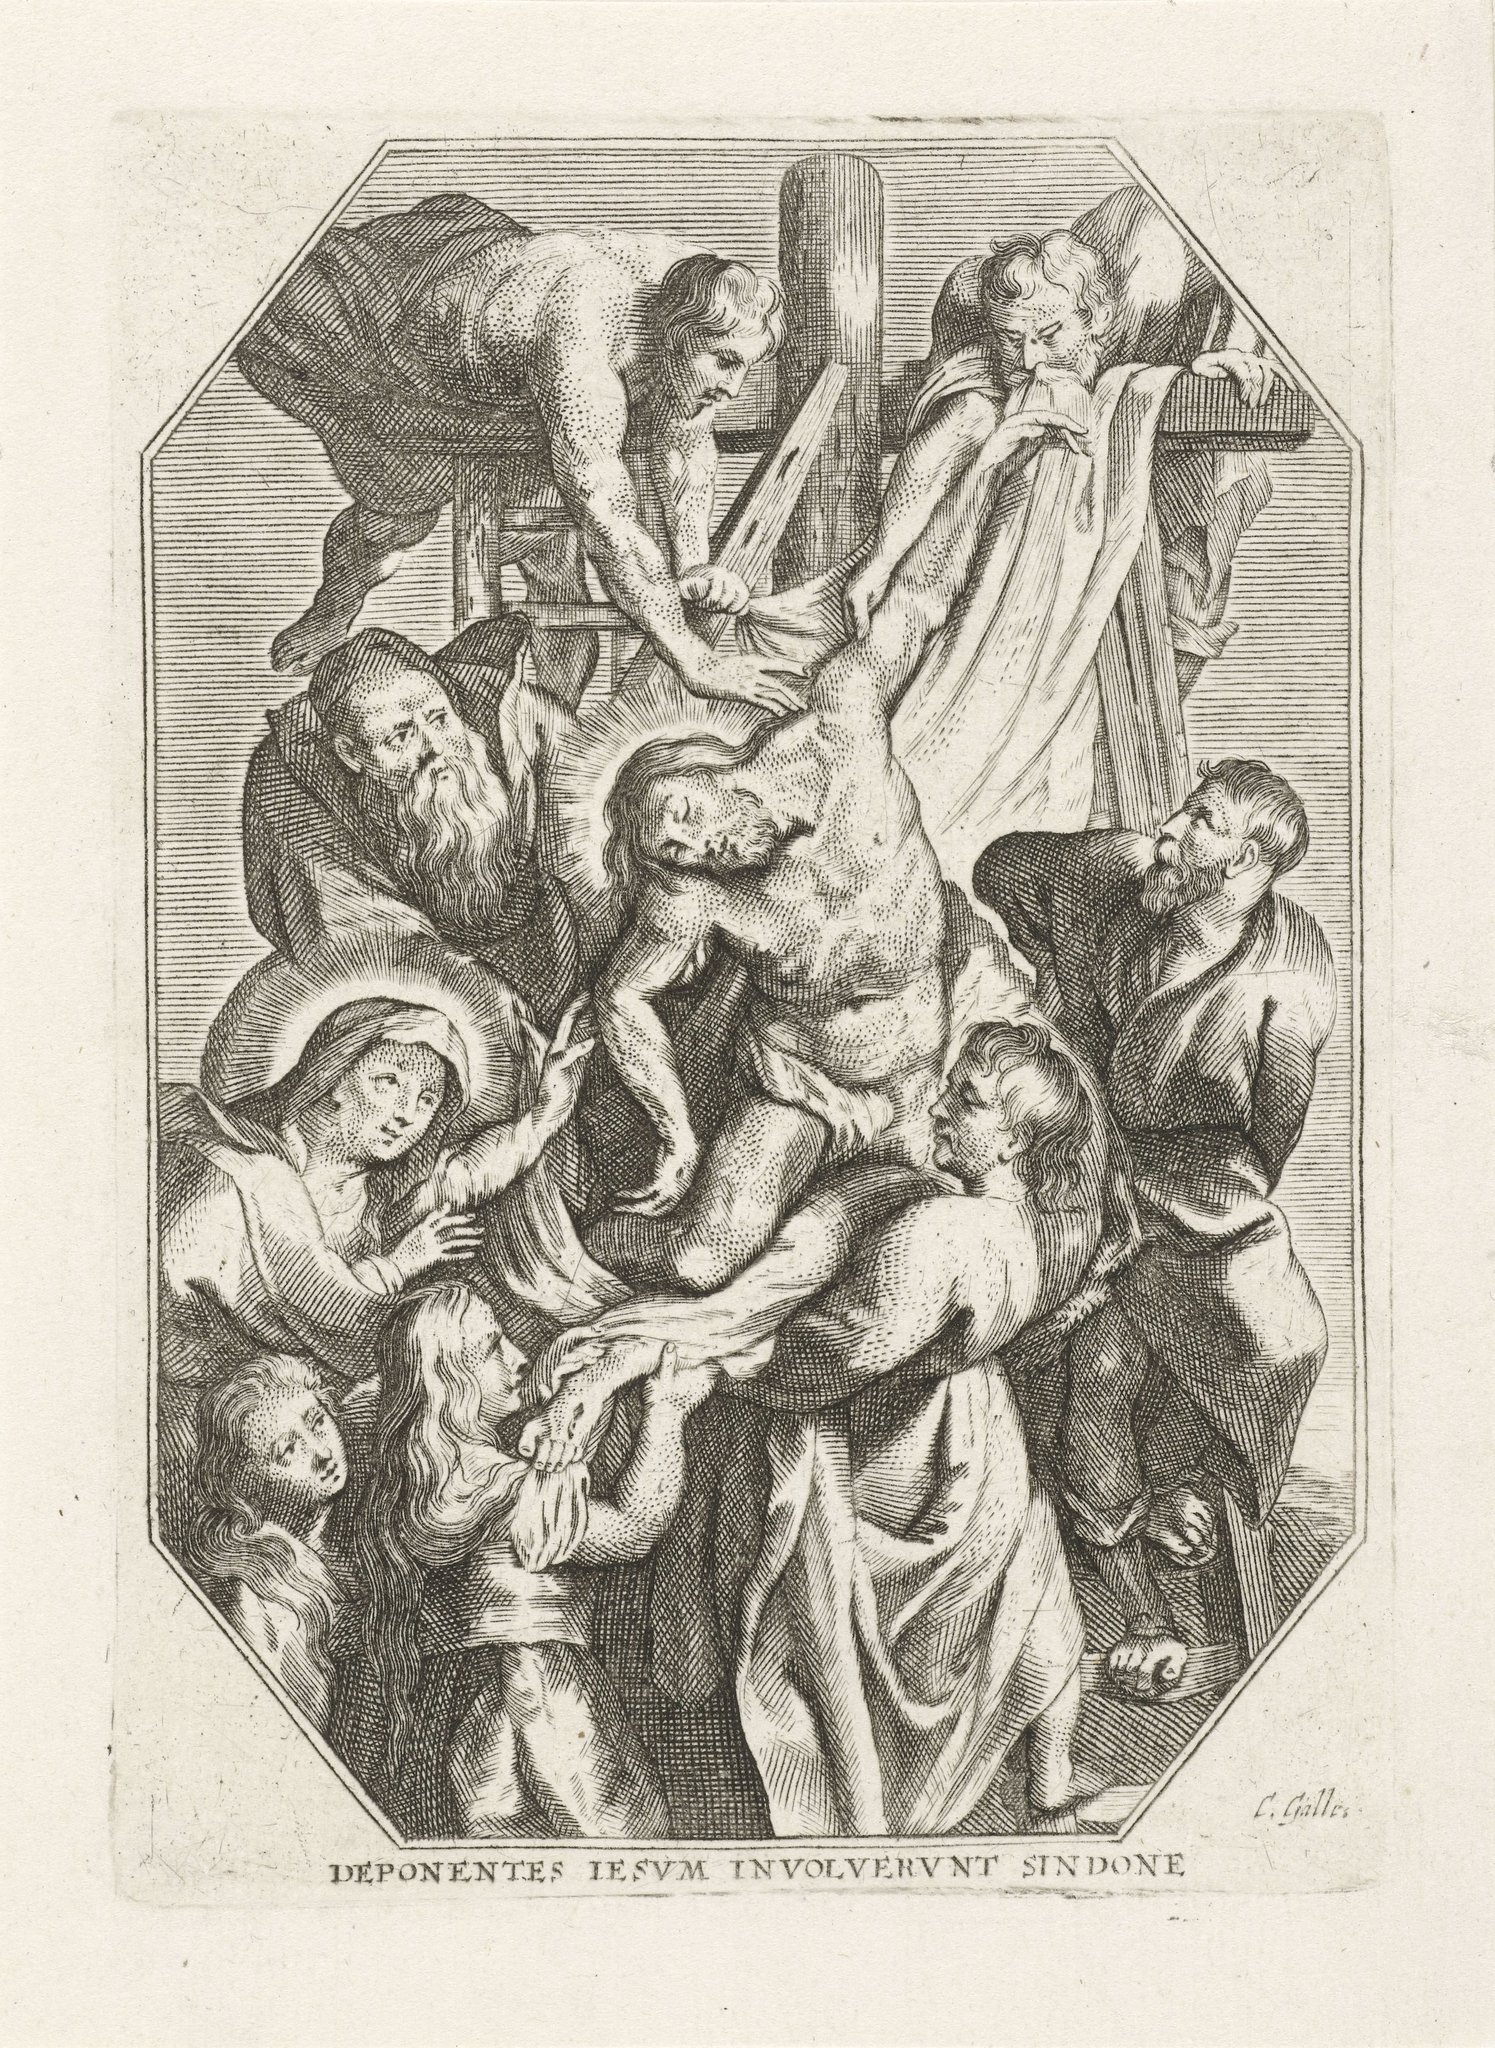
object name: print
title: Kruisafneming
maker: cornelis galle (i)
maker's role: print maker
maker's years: 1576-1650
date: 1586-1650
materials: paper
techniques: engraving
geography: southern netherlands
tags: descent from the cross: christ is taken down from the cross, usually by nicodemus and joseph of arimathaea who are standing on the ladders (both arms of christ detached)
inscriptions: collector's mark: Lugt 2228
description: Jozef en Nikodemus halen het lichaam van Christus van het kruis. Johannes, Maria en Maria Magdalena steunen het lichaam. Elfde prent uit een serie van 13, met voorstellingen uit het lijdensverhaal van Christus.